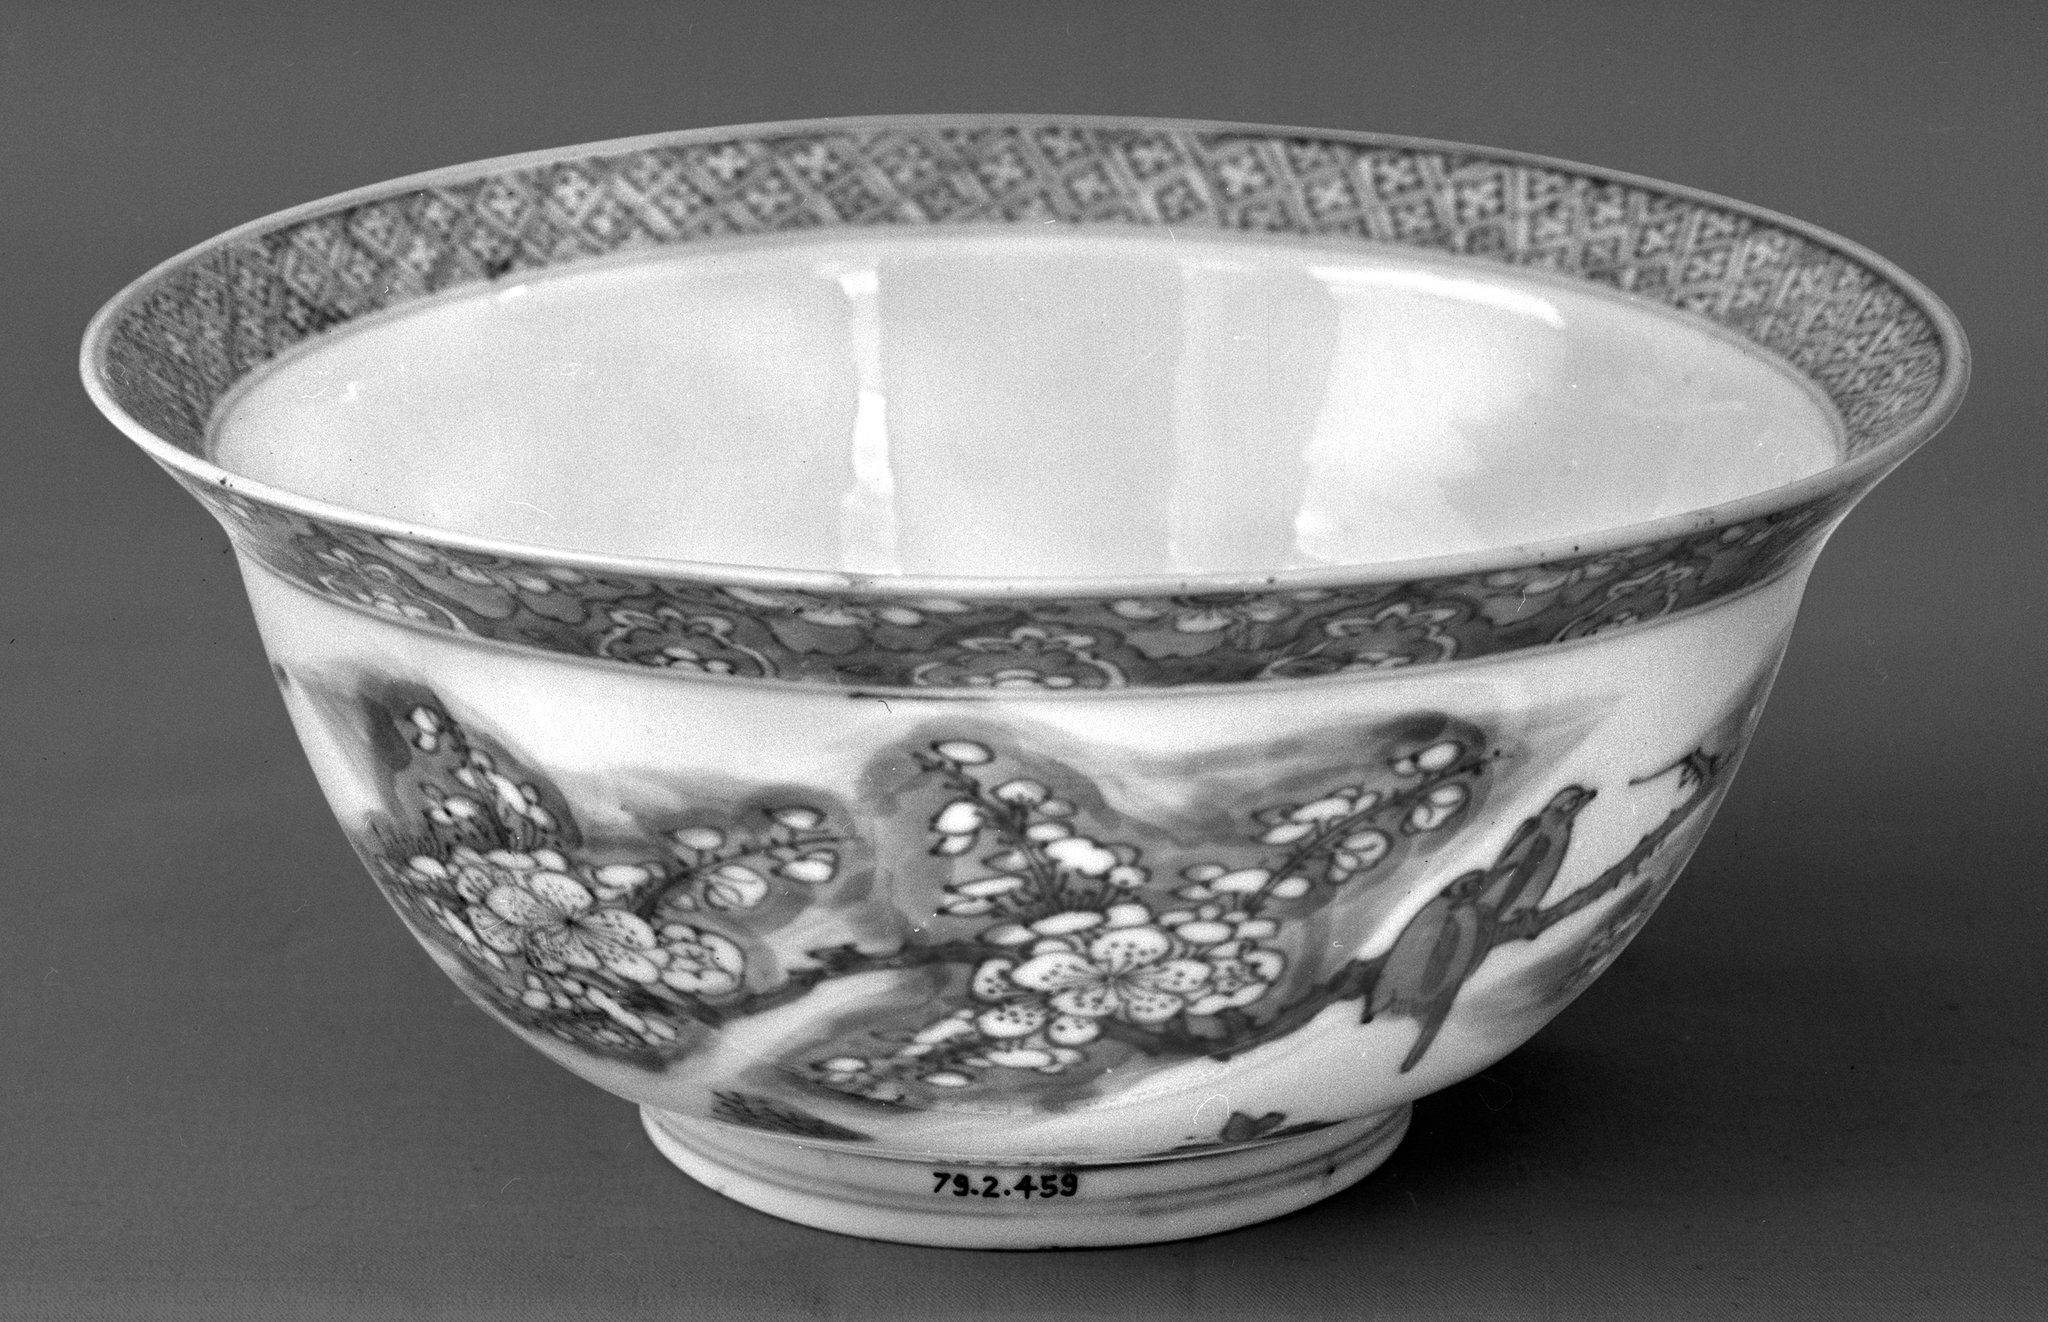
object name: bowl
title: Bowl with birds and flowers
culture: chinese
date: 1667-1700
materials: cobalt, porcelain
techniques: painting, underglaze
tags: birds